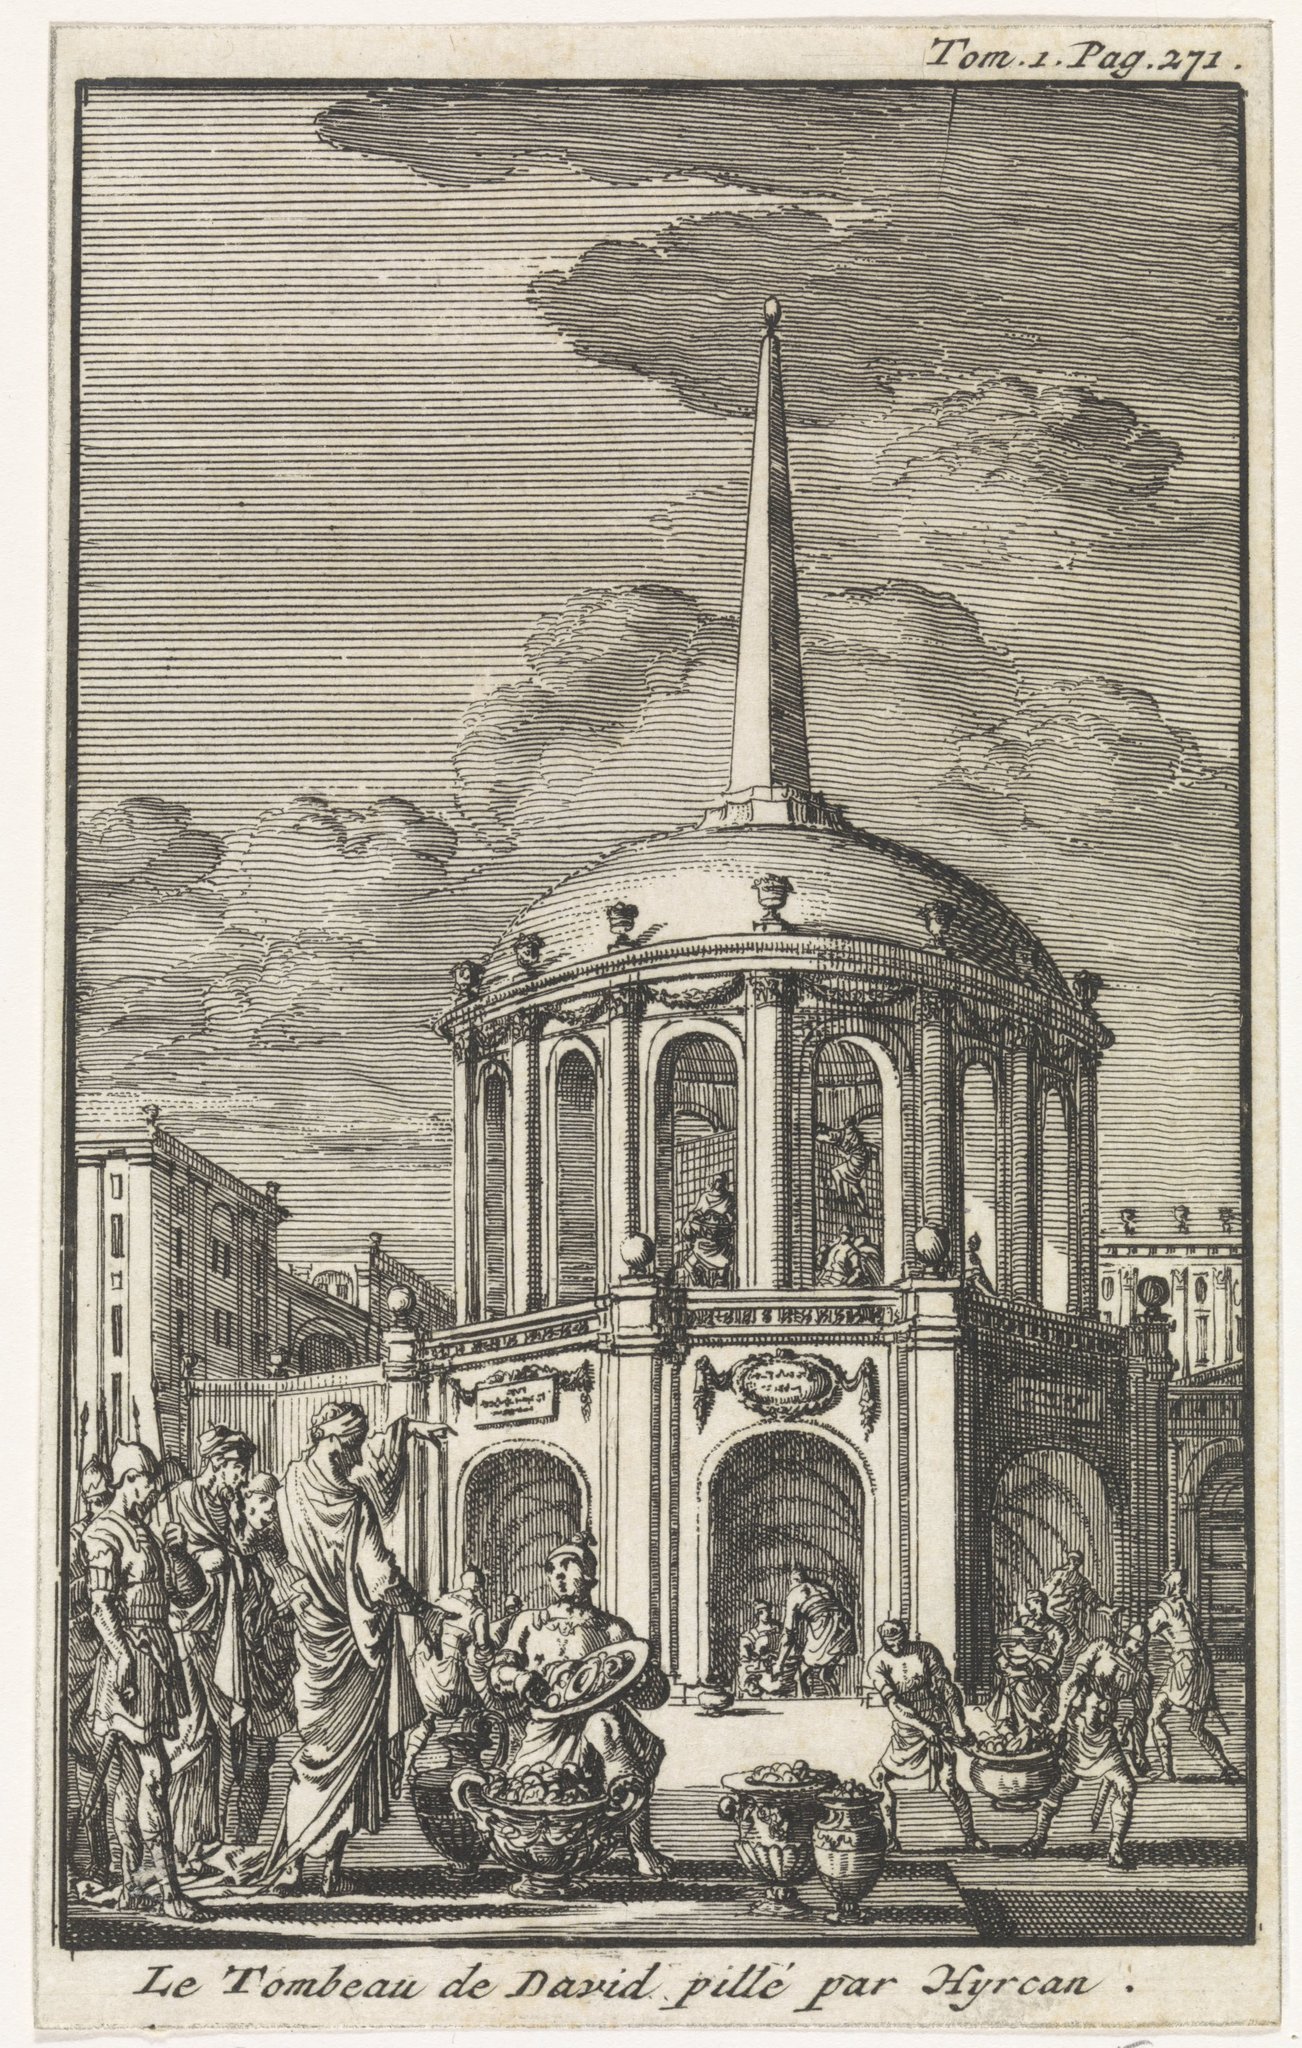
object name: book illustration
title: Hyrcanus plundert het graf van David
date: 1705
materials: paper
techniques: etching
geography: amsterdam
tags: plundering of david's grave by johannes hyrcanus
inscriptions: collector's mark: Lugt 2228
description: Illustratie uit: Cunaeus, Petrus. La republique des Hebreux, 3 delen. Amsterdam: Pieter Mortier, 1705, dl. I, p. 271.